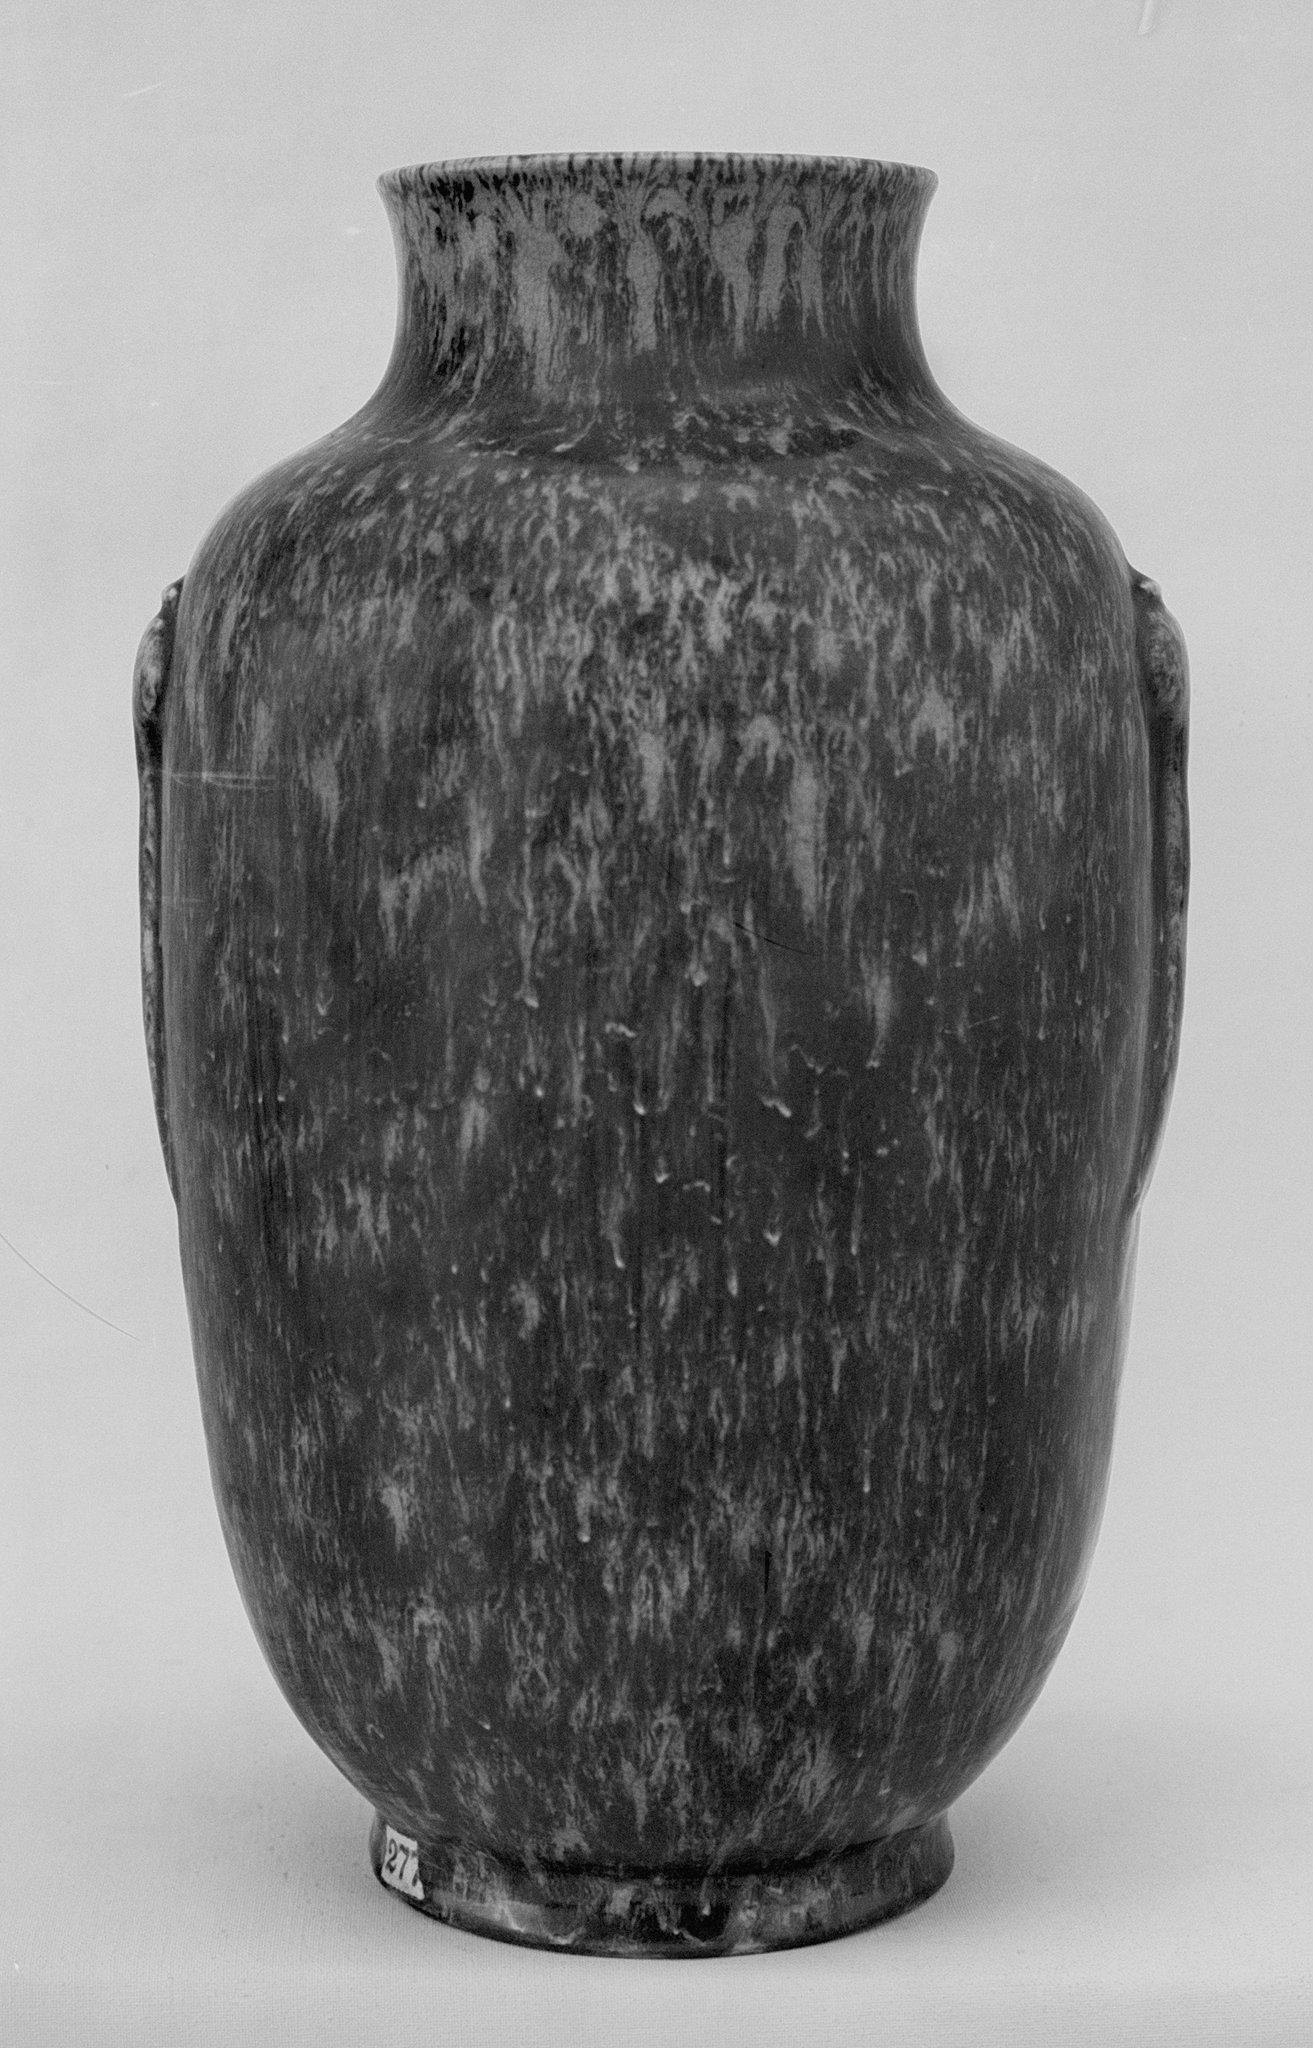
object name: vase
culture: chinese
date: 1801-1850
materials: glaze, porcelain